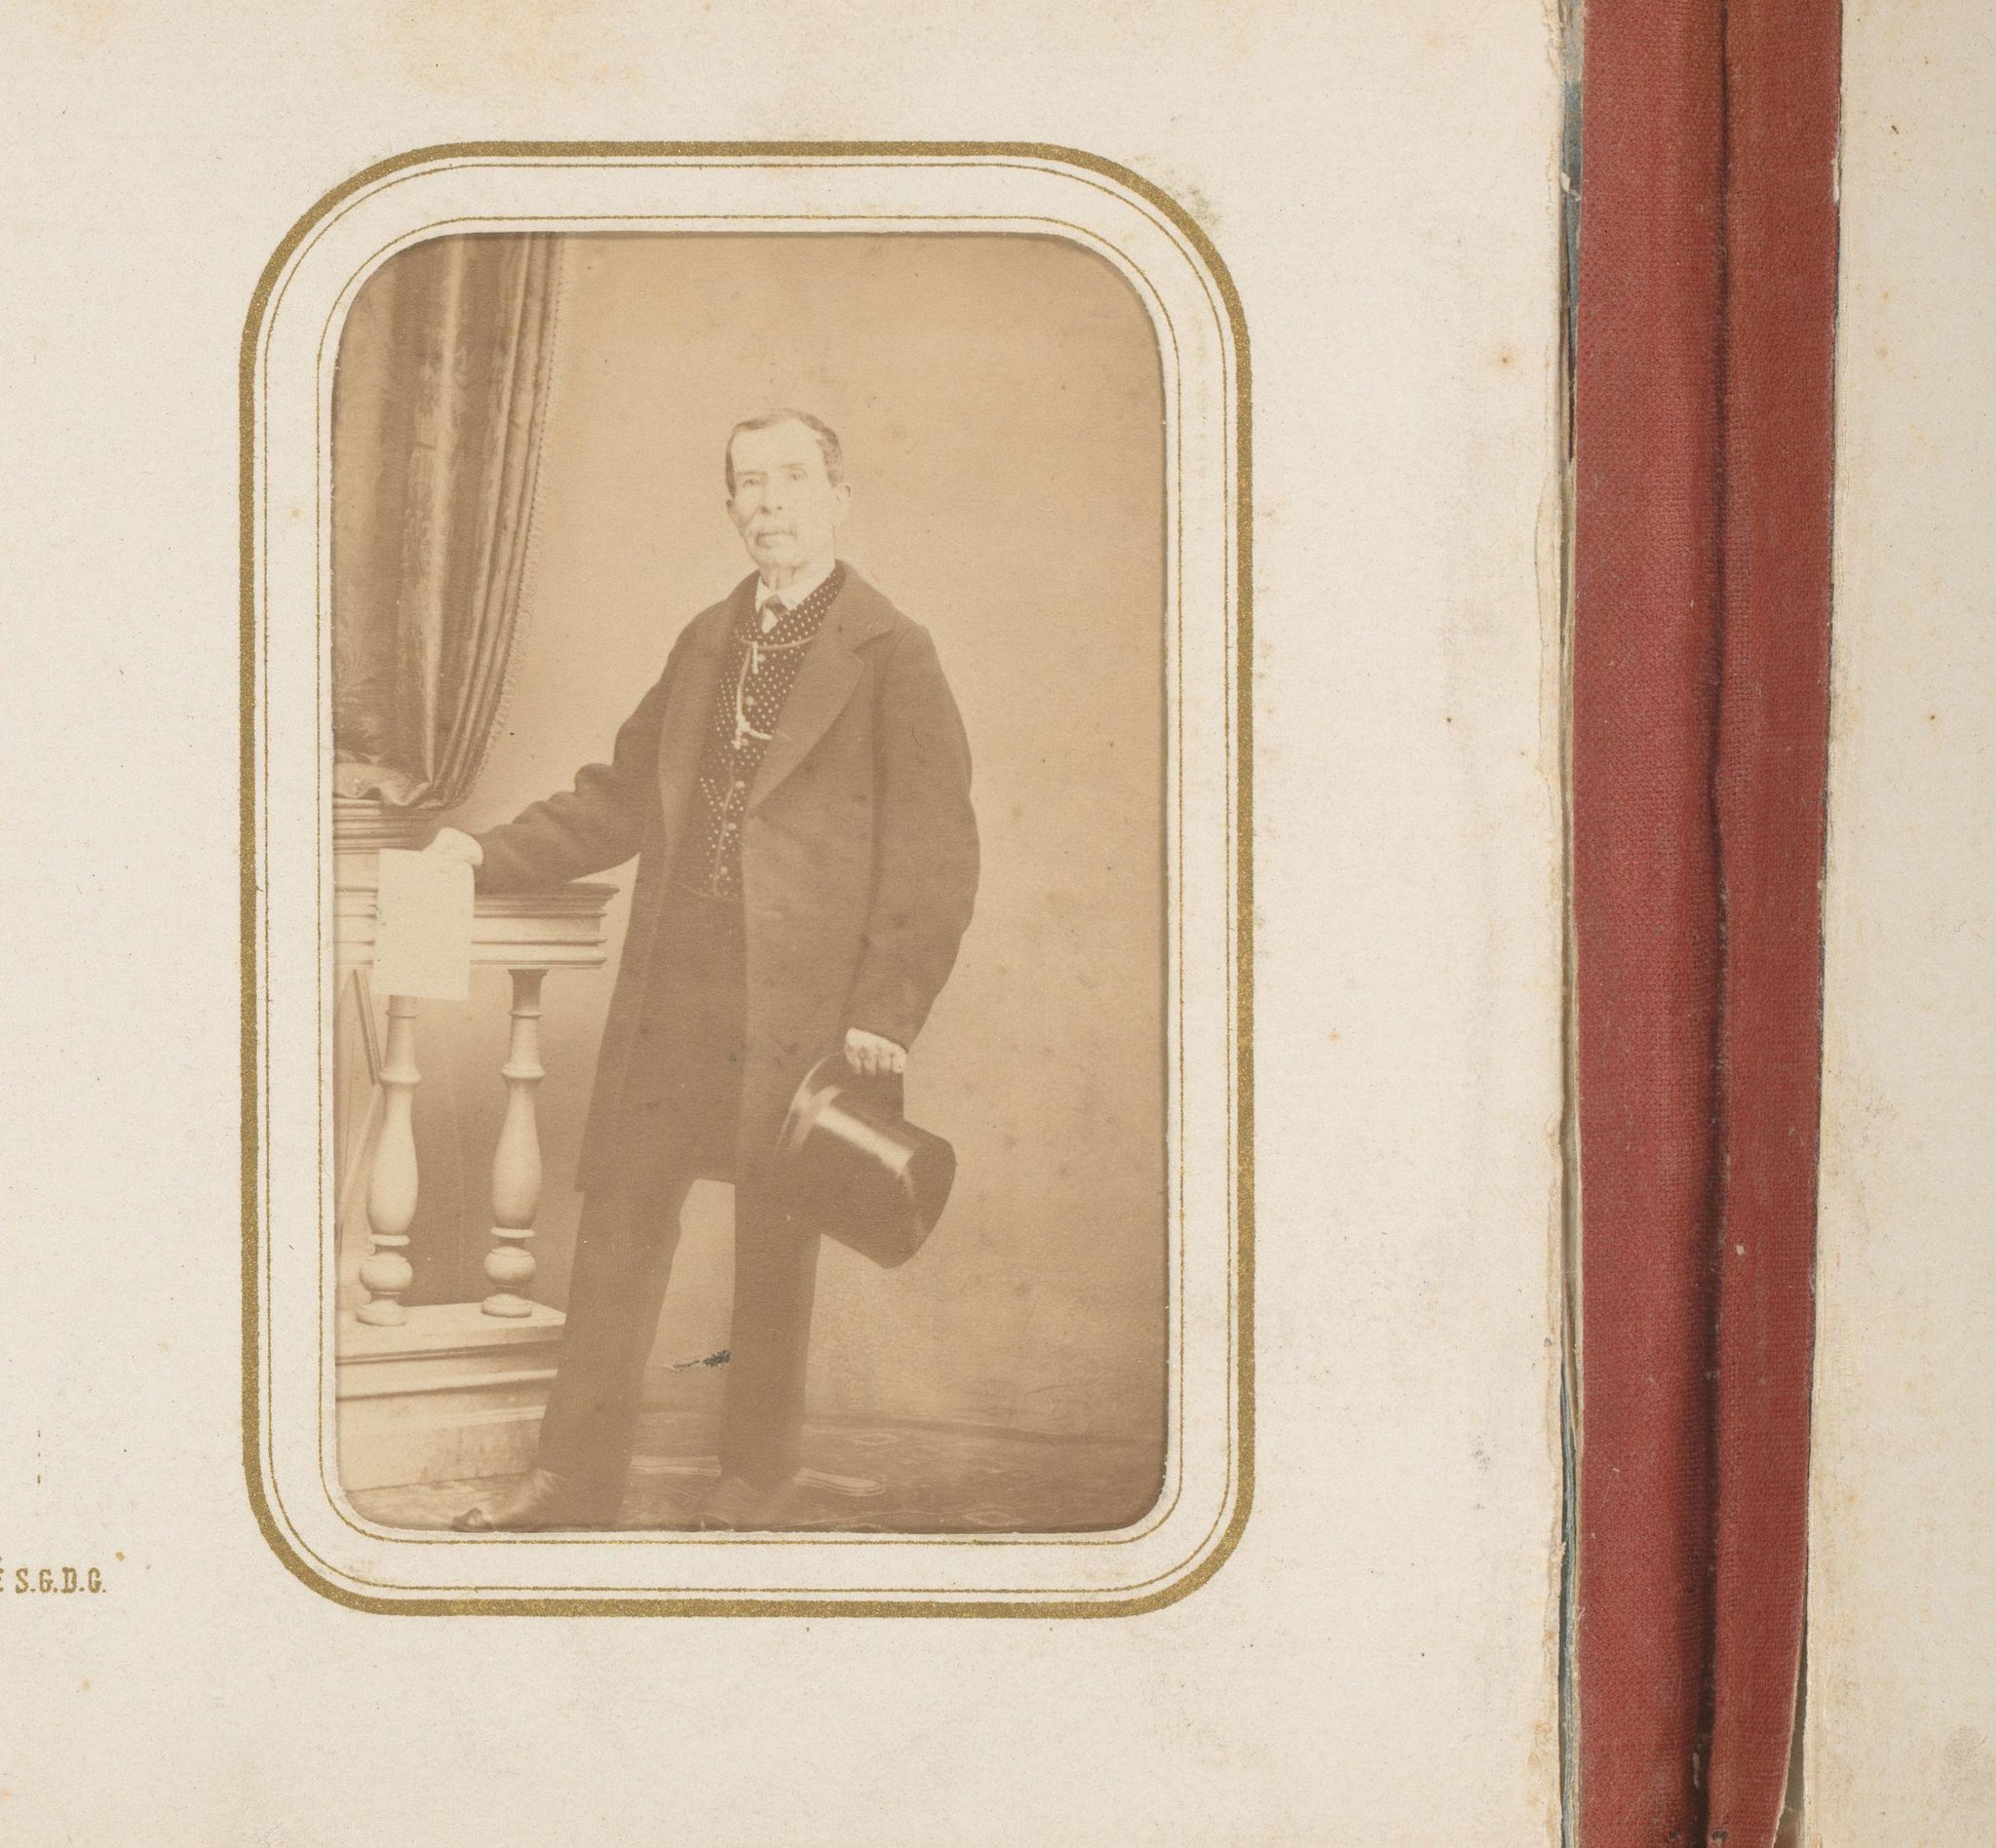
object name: photograph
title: Portret van een man met in de hand een hoge hoed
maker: josé martínez sanchez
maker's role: fotograaf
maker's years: 1807-1874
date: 1860-1900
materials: cardboard, photographic support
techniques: albumen print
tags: adult man, historical persons, head-gear: top hat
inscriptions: inscription: ‘J. Sanchez/ Puerta del Sol 15/ Madrid’